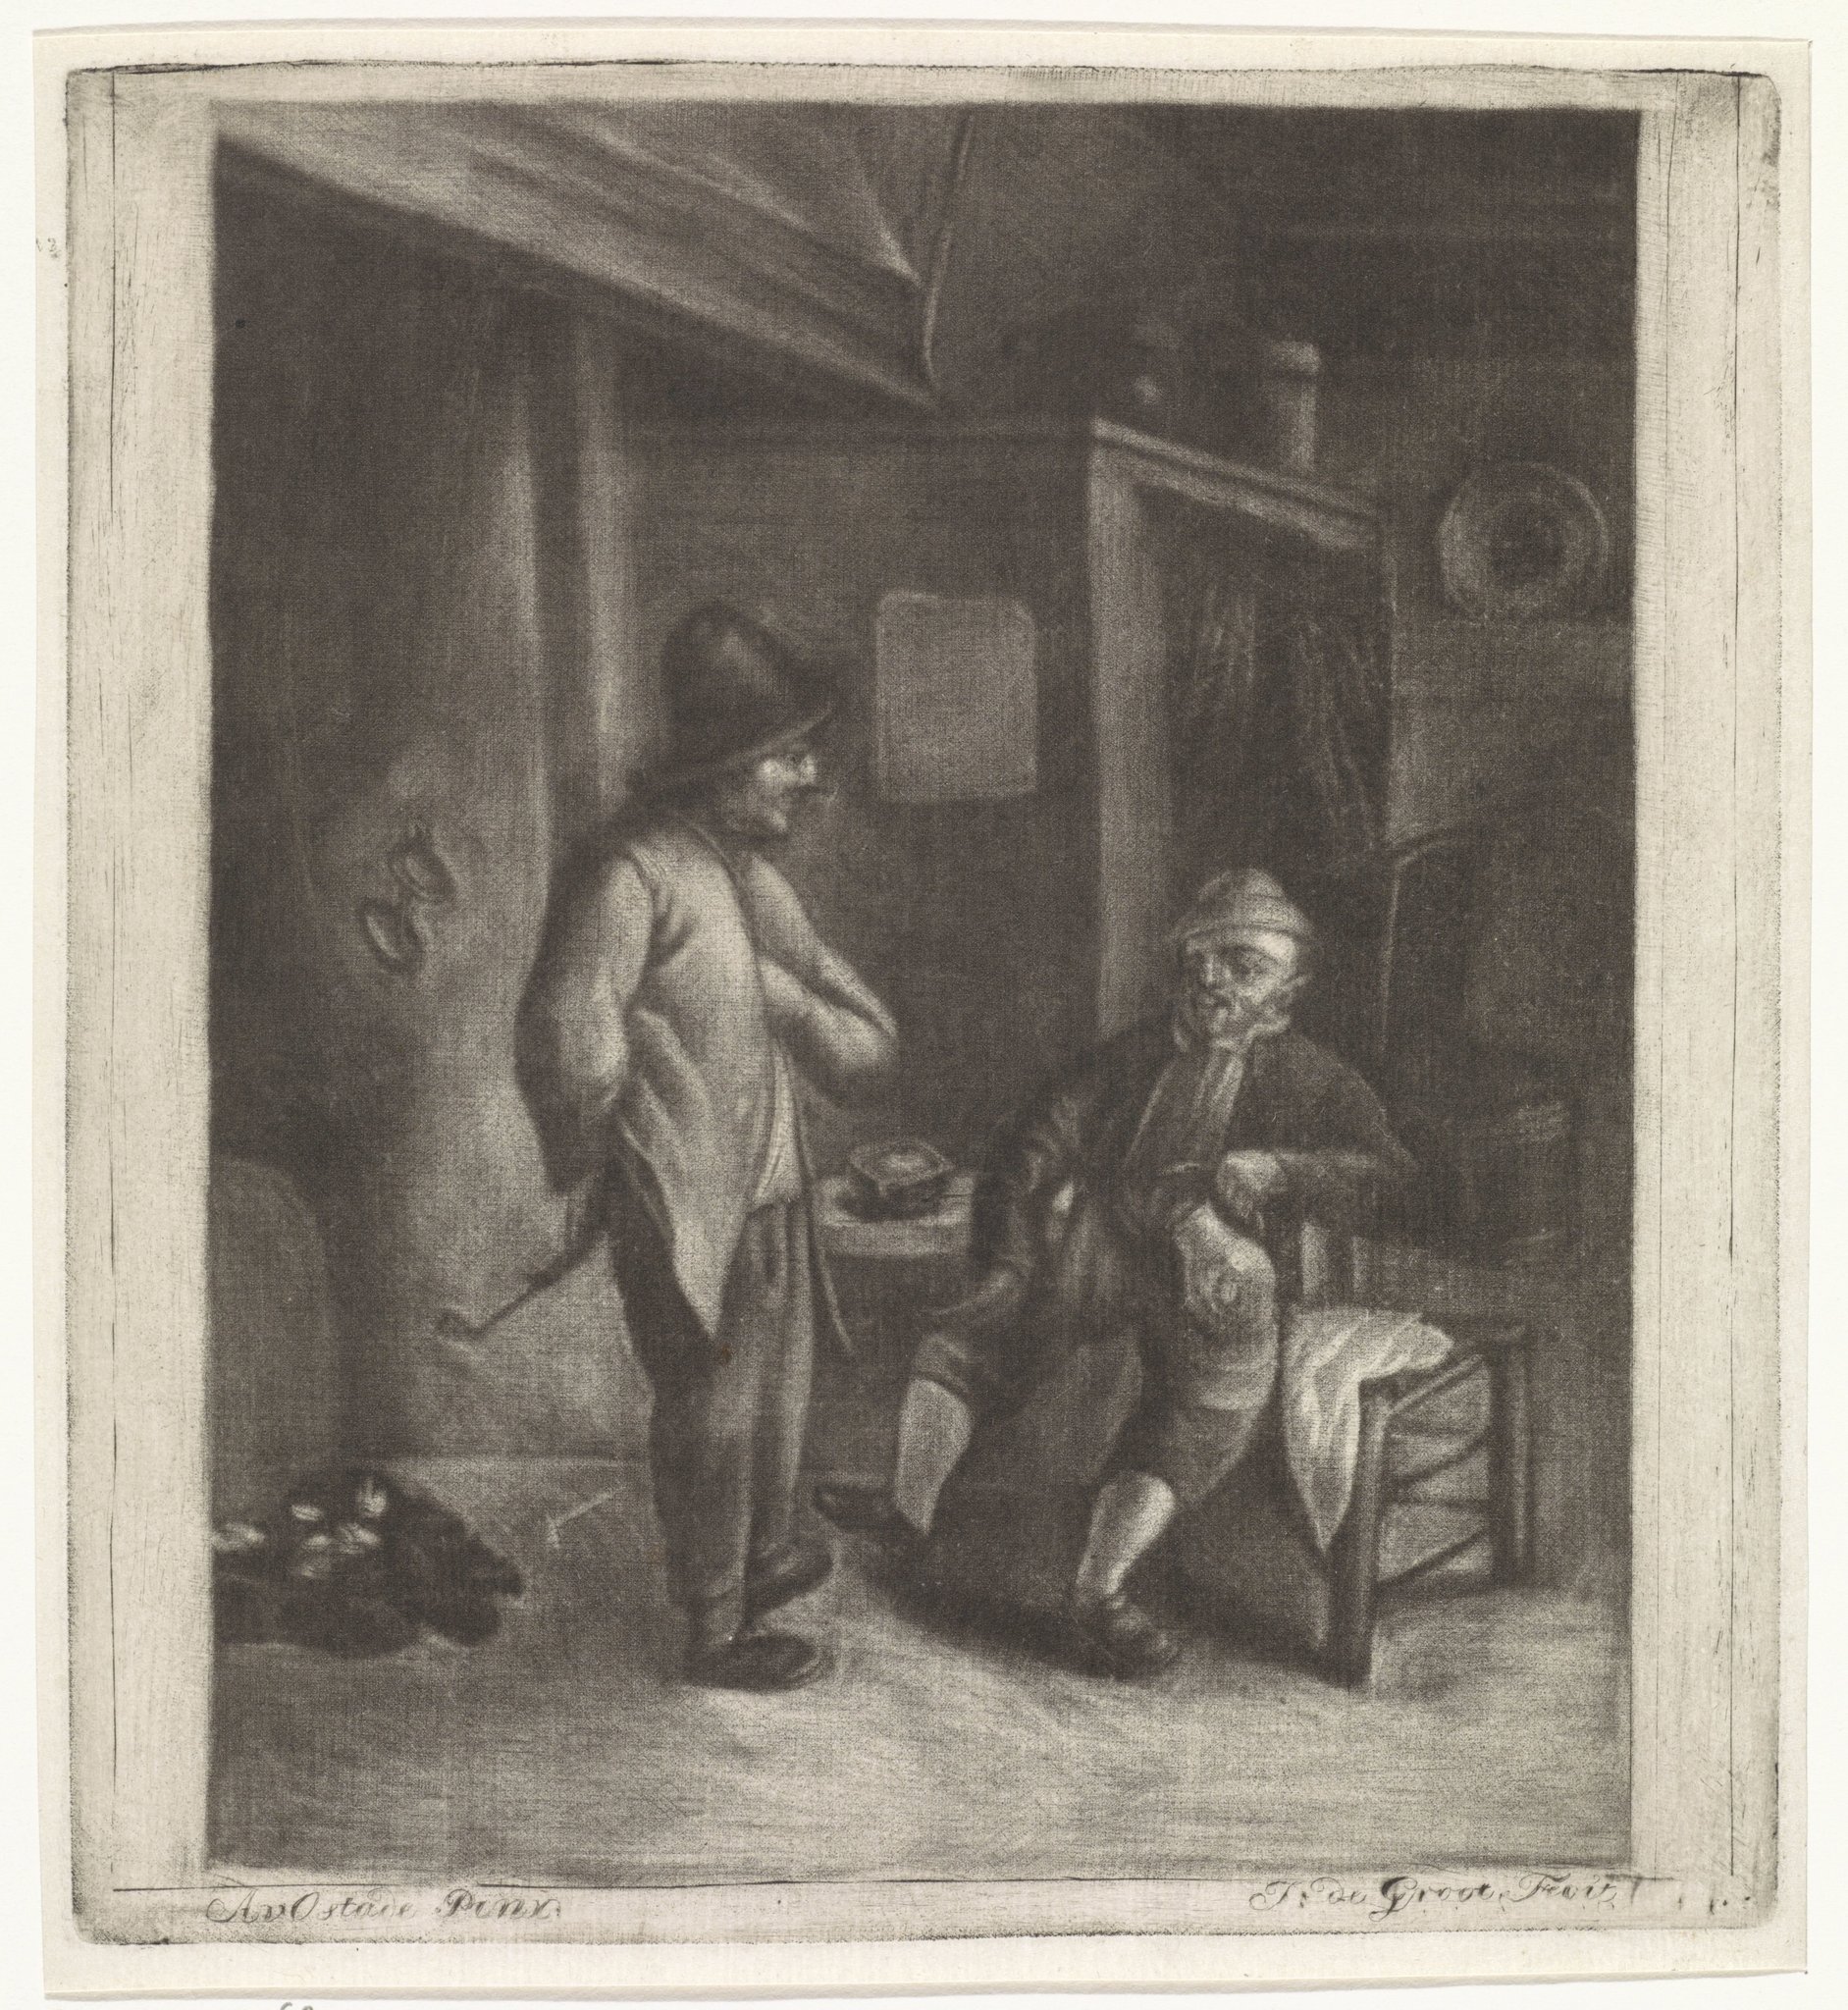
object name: print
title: Twee mannen in een herberg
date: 1698-1776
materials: paper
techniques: engraving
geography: northern netherlands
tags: inn, coffee-house, public house, etc., pipe ~ tobacco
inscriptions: collector's mark: Lugt 240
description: In een herberg bevinden zich twee mannen bij de haard. Een van de mannen heeft een pijp en de andere een kan met drank.